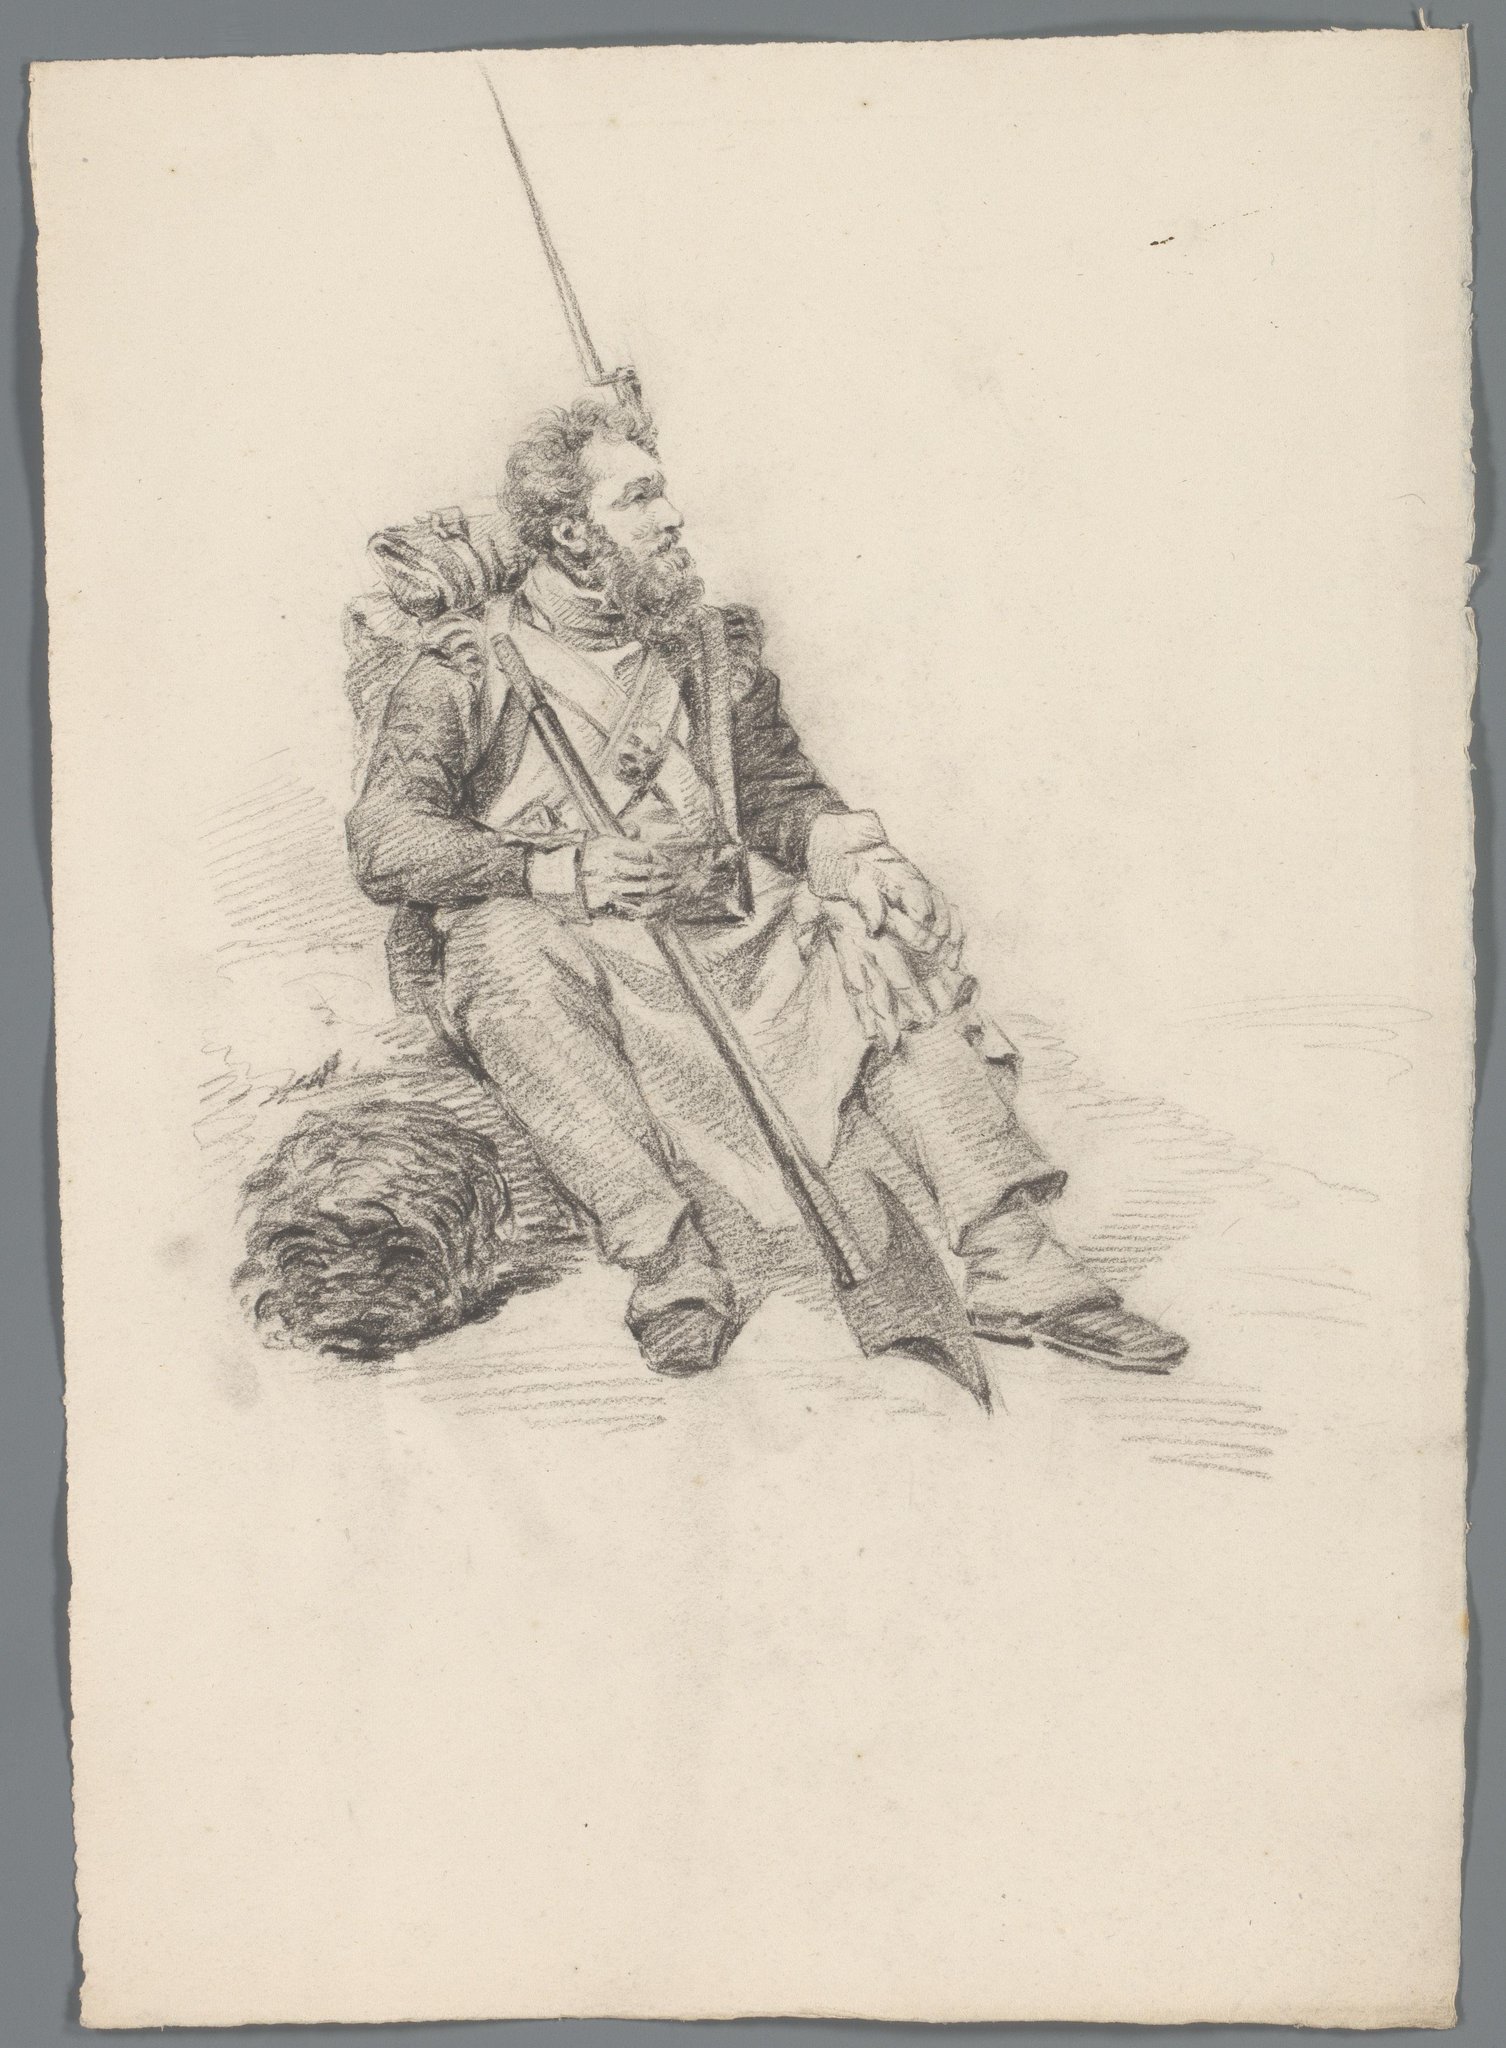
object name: drawing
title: Zittende soldaat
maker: Anonymous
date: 1820-1830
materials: chalk, paper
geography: the hague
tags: private soldier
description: Tekeningen waarschijnlijk ontstaan bij het Haagse kunstgenootschap ‘Tot Nut der Tekenkunst’, waar twee keer per week tekenavonden werden georganiseerd met geklede modellen.